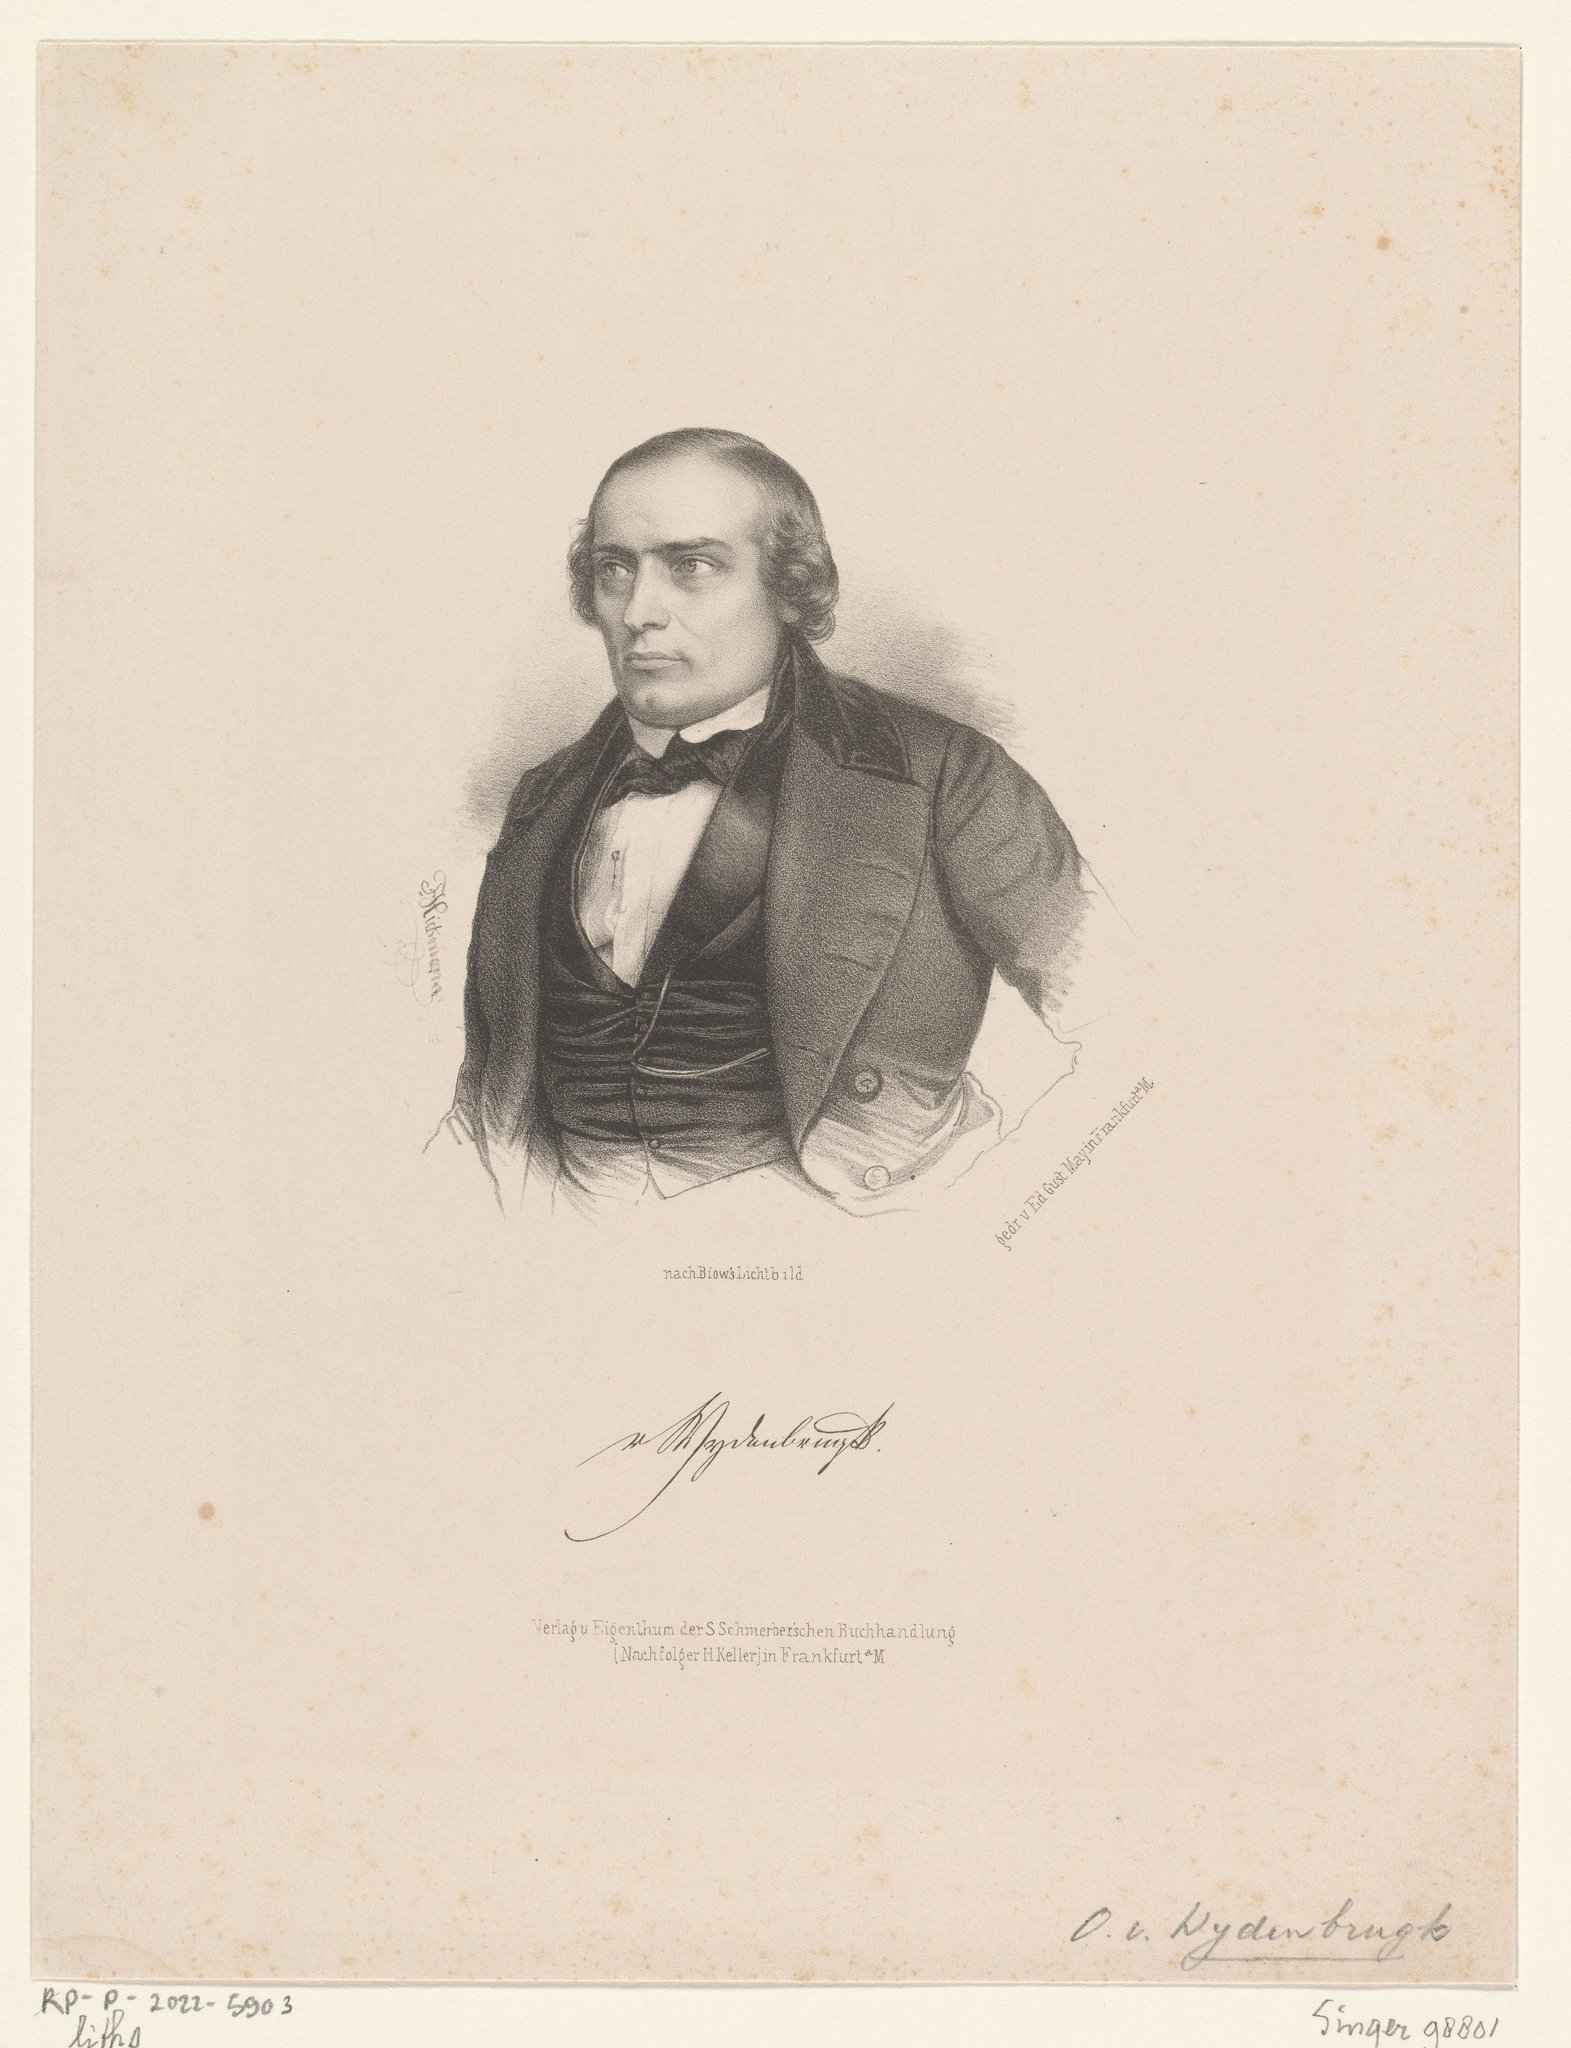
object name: book illustration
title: Portret van Oskar von Wydenbrugk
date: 1848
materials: paper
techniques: lithograph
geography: frankfurt am main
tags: historical persons, politician, e.g. party leader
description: Prent waarschijnlijk uit: Die Männer des deutschen Volks (...). Frankfurt am Main: S. Schmerber'schen Buchhandlung, 1848, dl. 2.